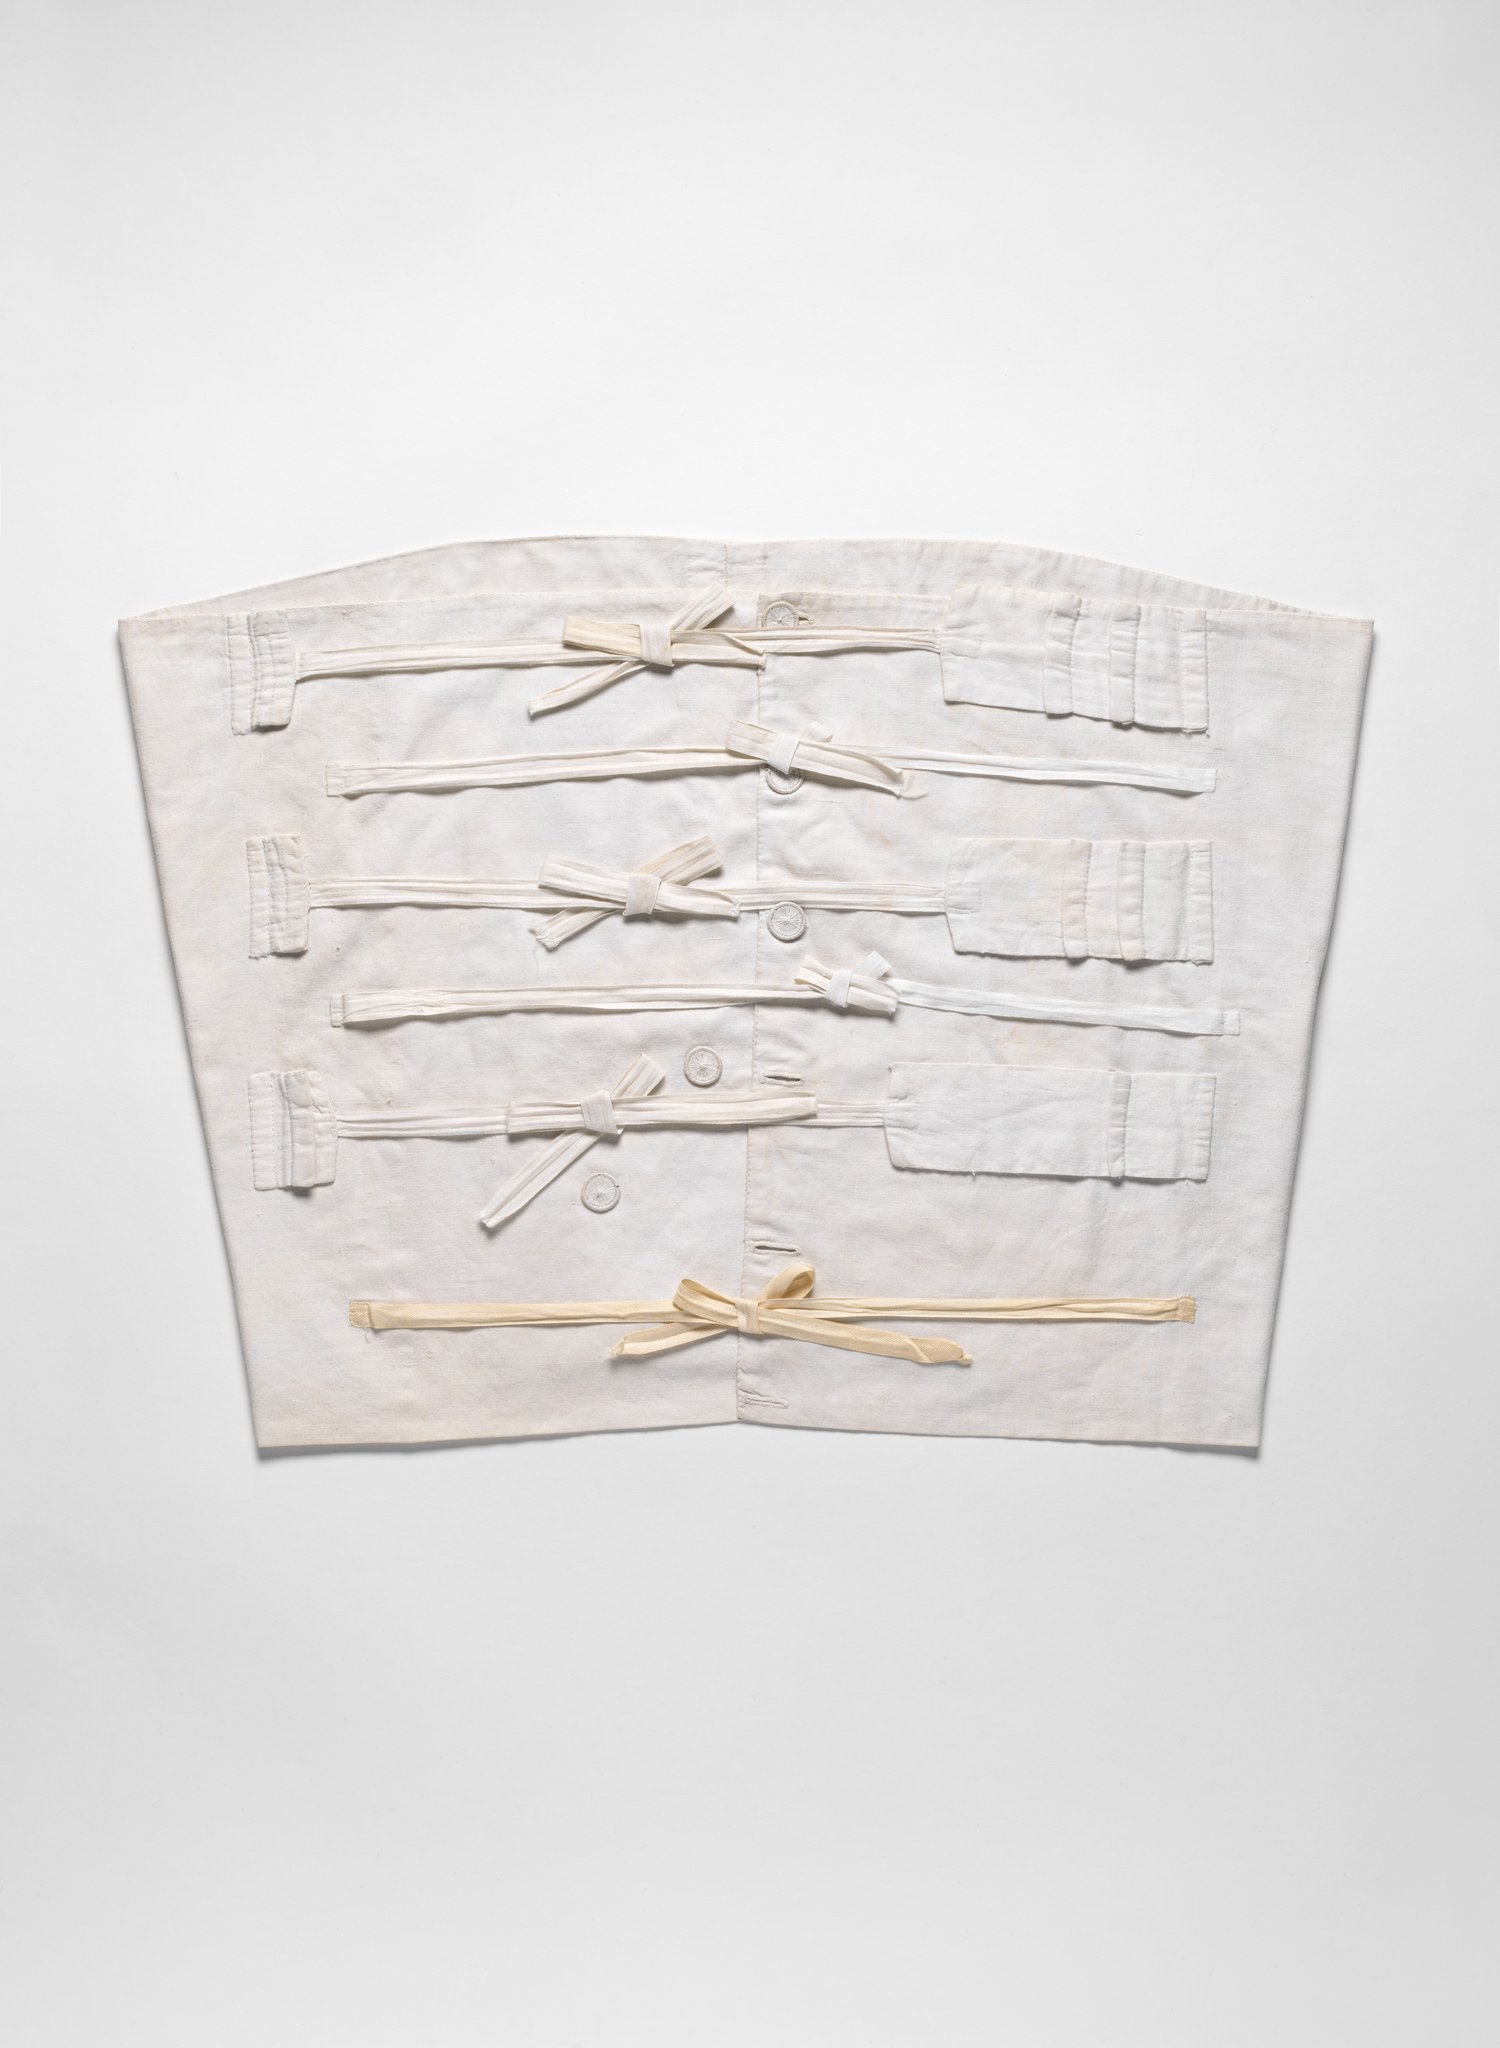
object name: corset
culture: american or european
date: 1801-1833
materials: cotton